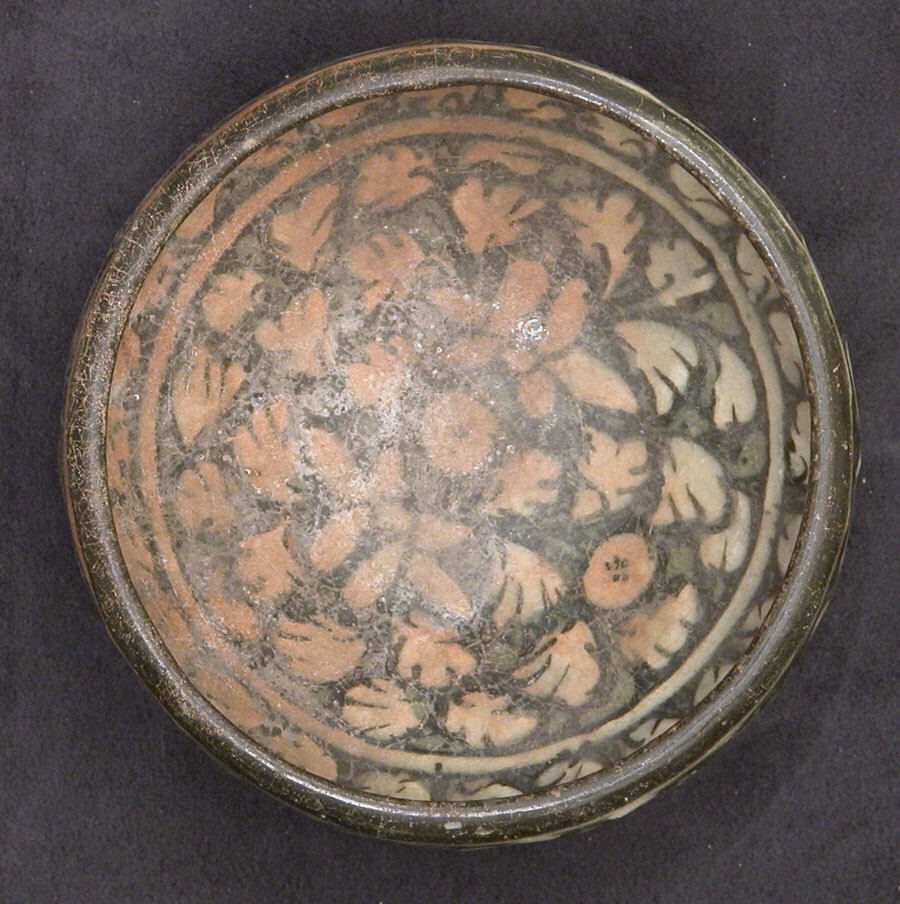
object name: bowl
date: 1301-1400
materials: stonepaste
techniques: painting, underglaze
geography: iran